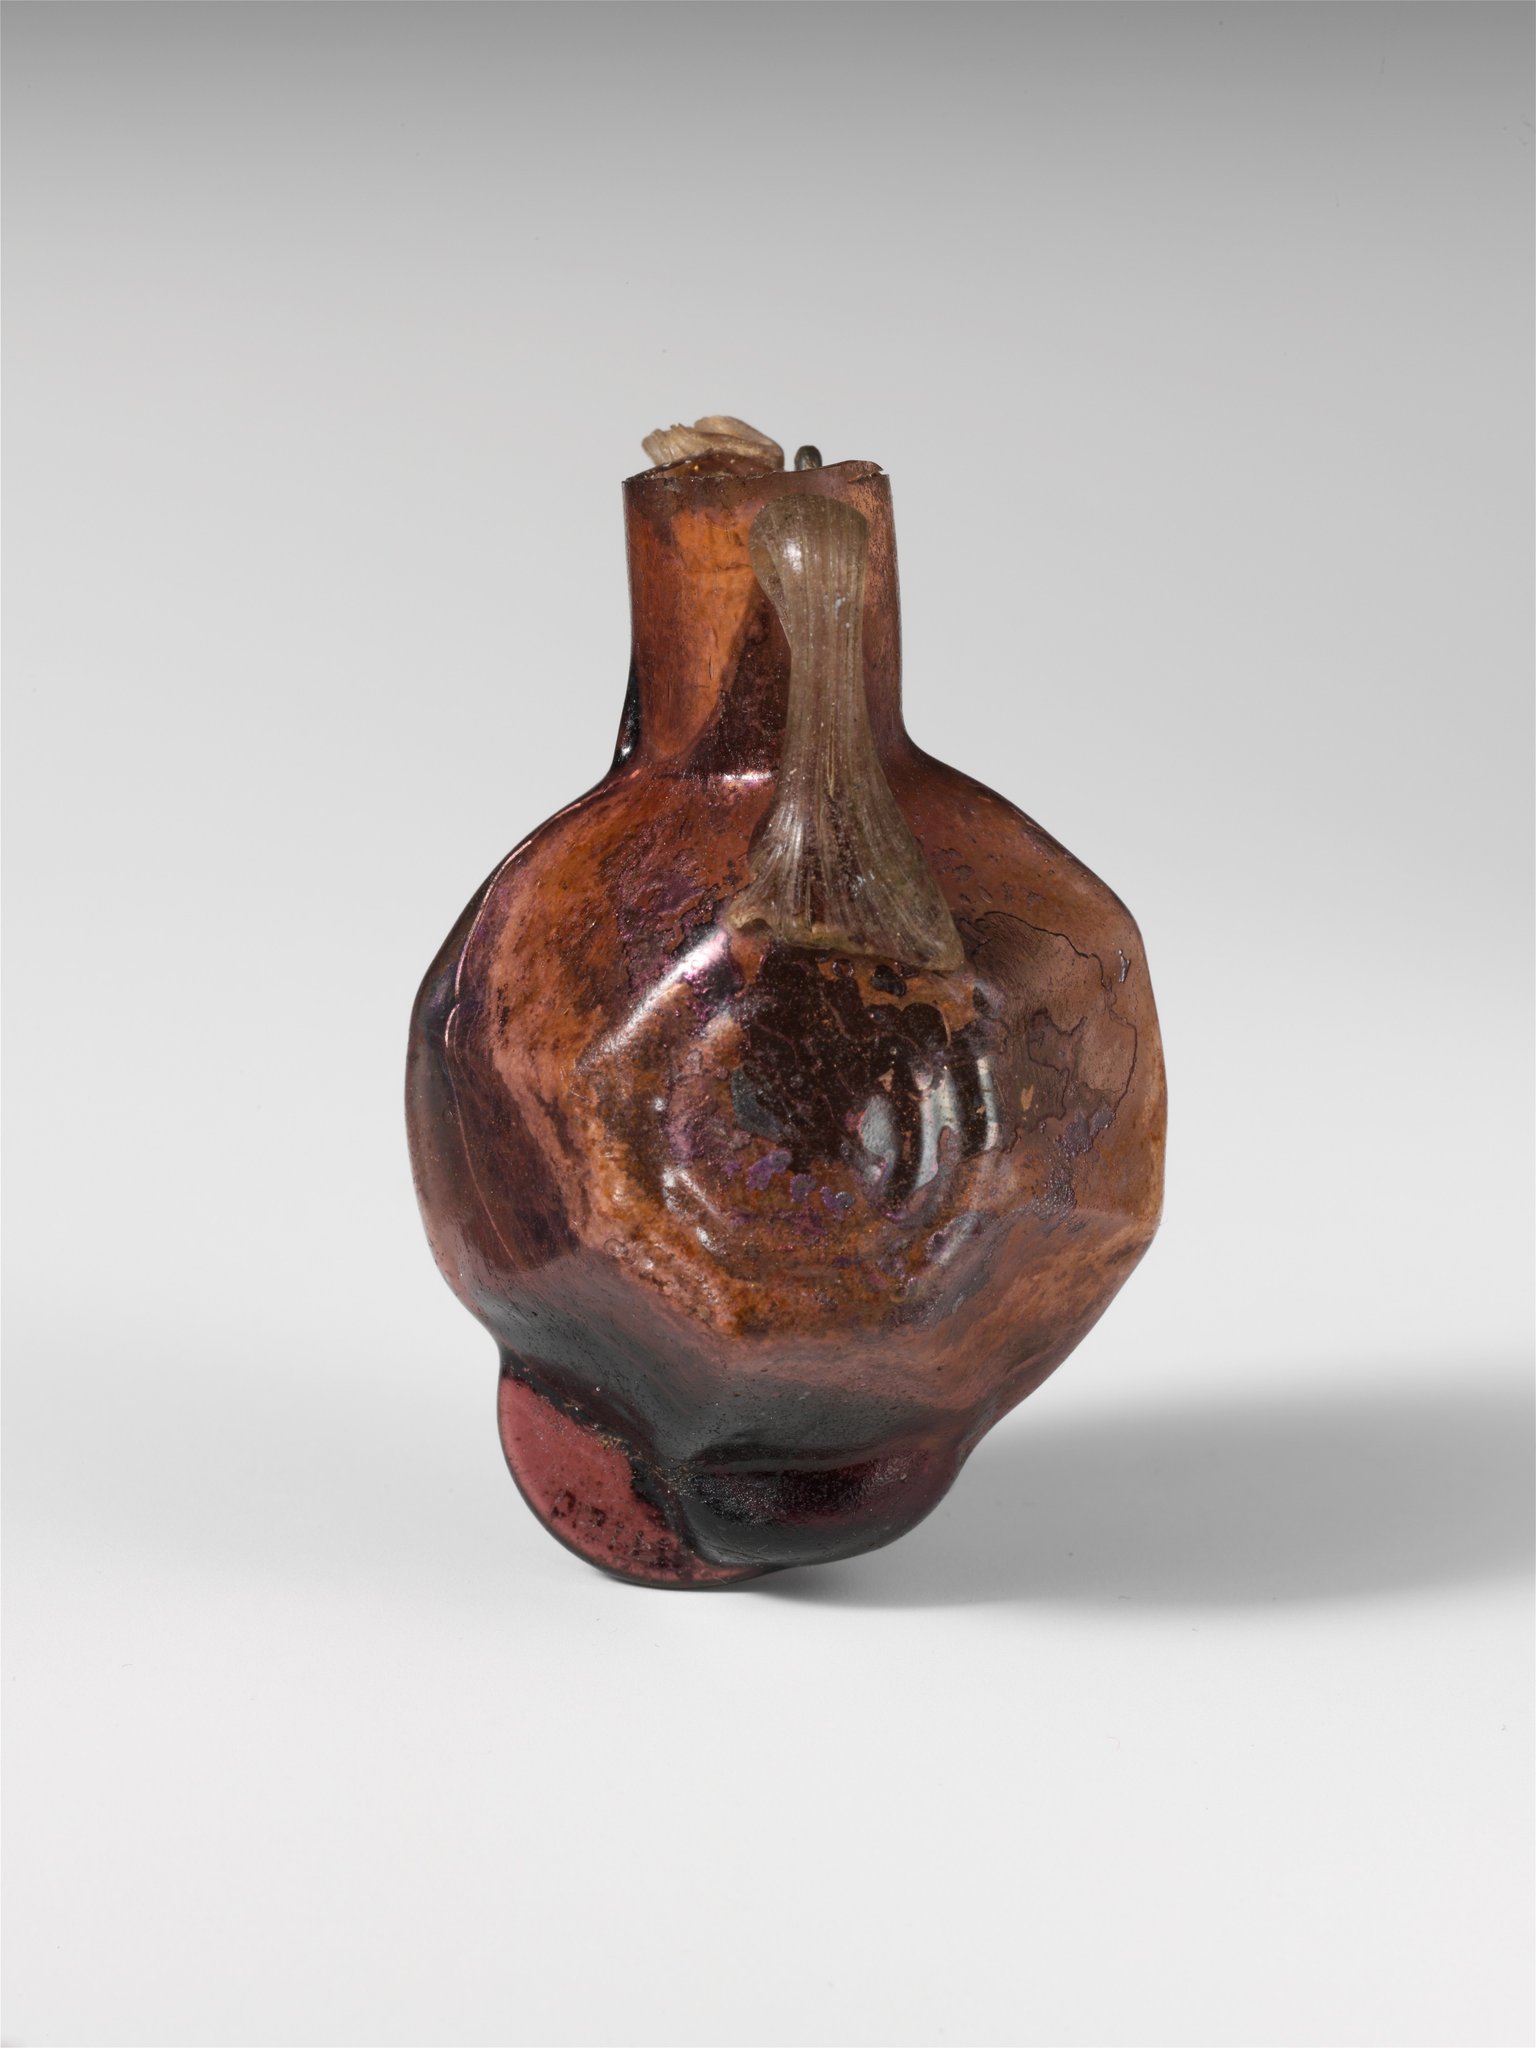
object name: bottle, multi sided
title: Glass multi-sided bottle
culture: roman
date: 1-100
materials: glass